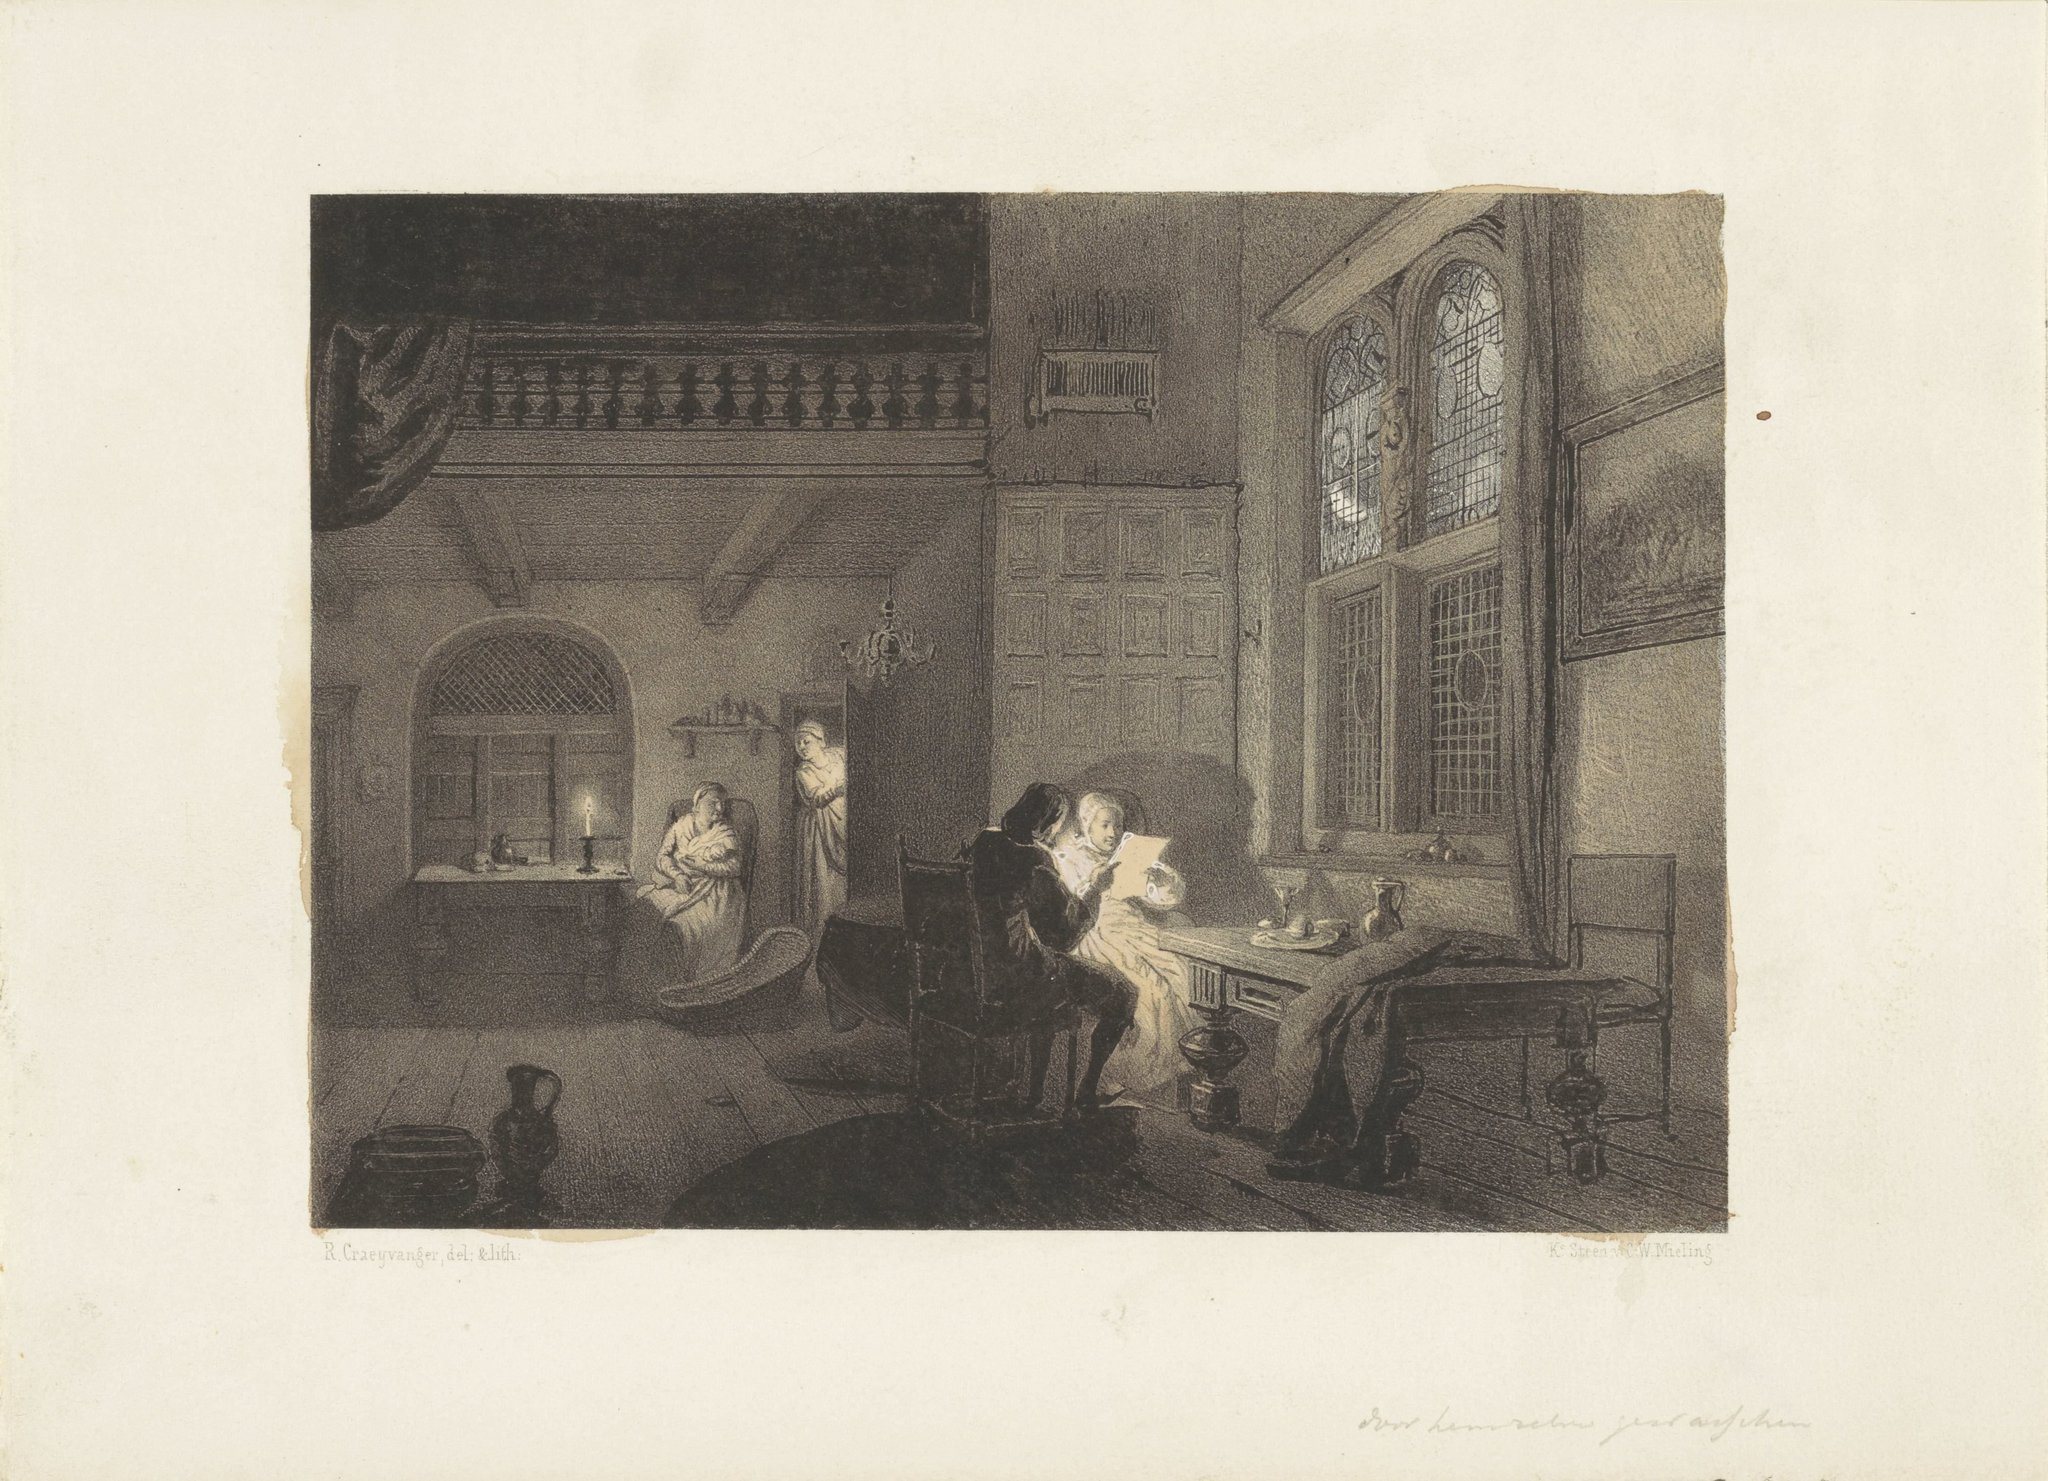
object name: print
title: Binnenhuis met figuren bij kaarslicht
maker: reinier craeyvanger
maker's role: draughtsman, print maker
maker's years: 1812-1880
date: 1851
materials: paint, paper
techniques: brush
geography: the hague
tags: reading, candle, communal rooms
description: In een woonkamer zitten een man en vrouw bij een tafel bij kaarslicht een brief te lezen. Rechts van hen twee boogramen, daarnaast hangt een schilderij. Achterin de kamer zit een vrouw met een baby op haar schoot en komt een andere vrouw de deur binnen.